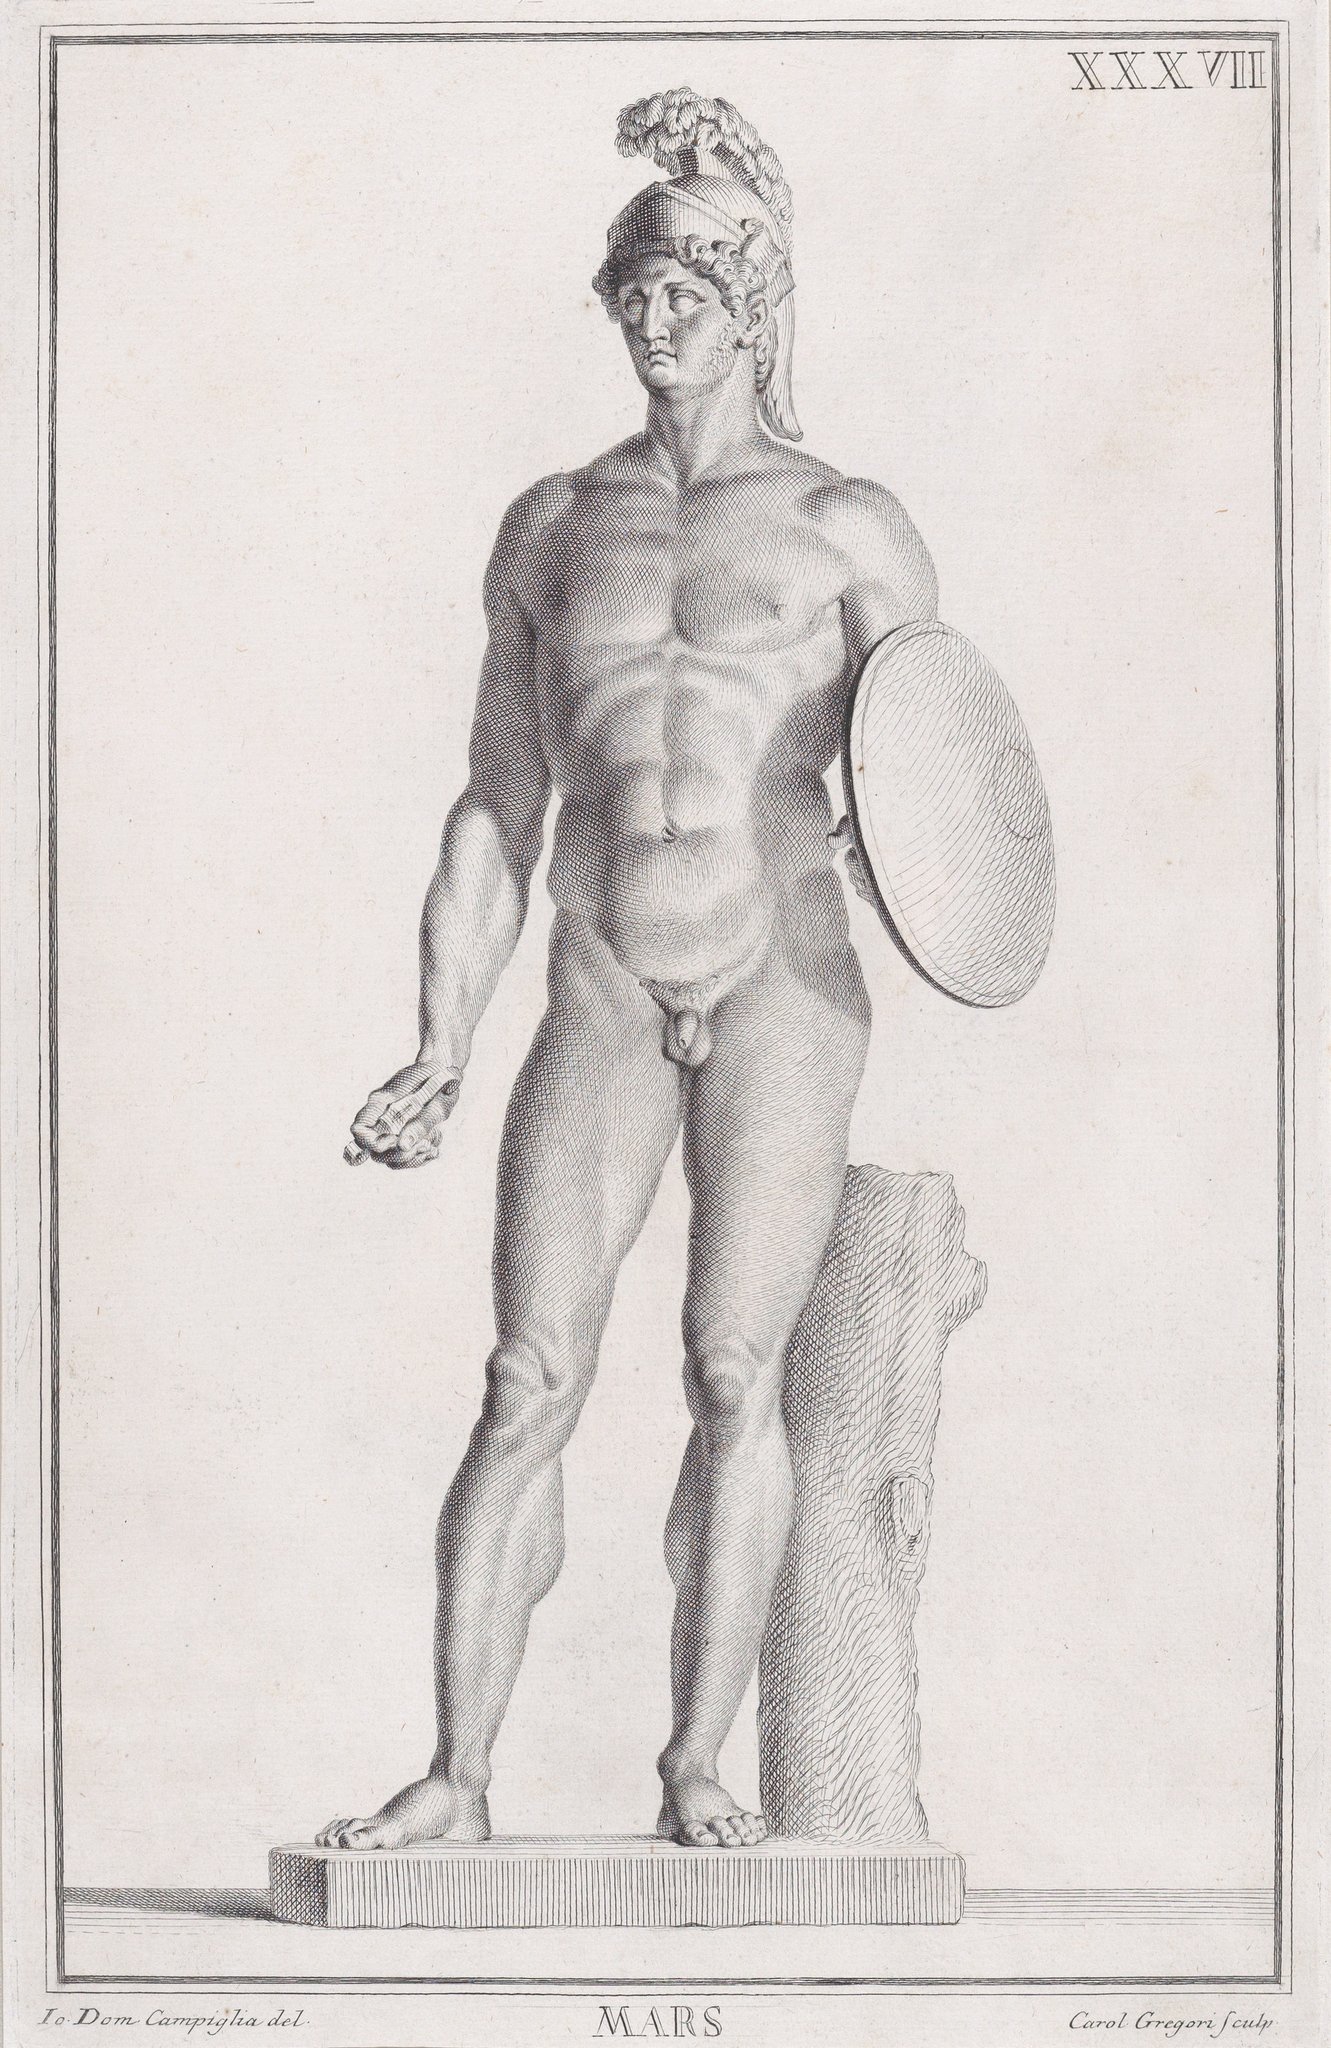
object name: print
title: Plate XXXVII (37): Mars, from "Museum Florentinum" (Statuae antiquae dorum et virorum illustrium)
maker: carlo gregori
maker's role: artist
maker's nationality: italian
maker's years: 1719-1759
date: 1734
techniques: engraving, etching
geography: florence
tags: shields,male nudes,mars